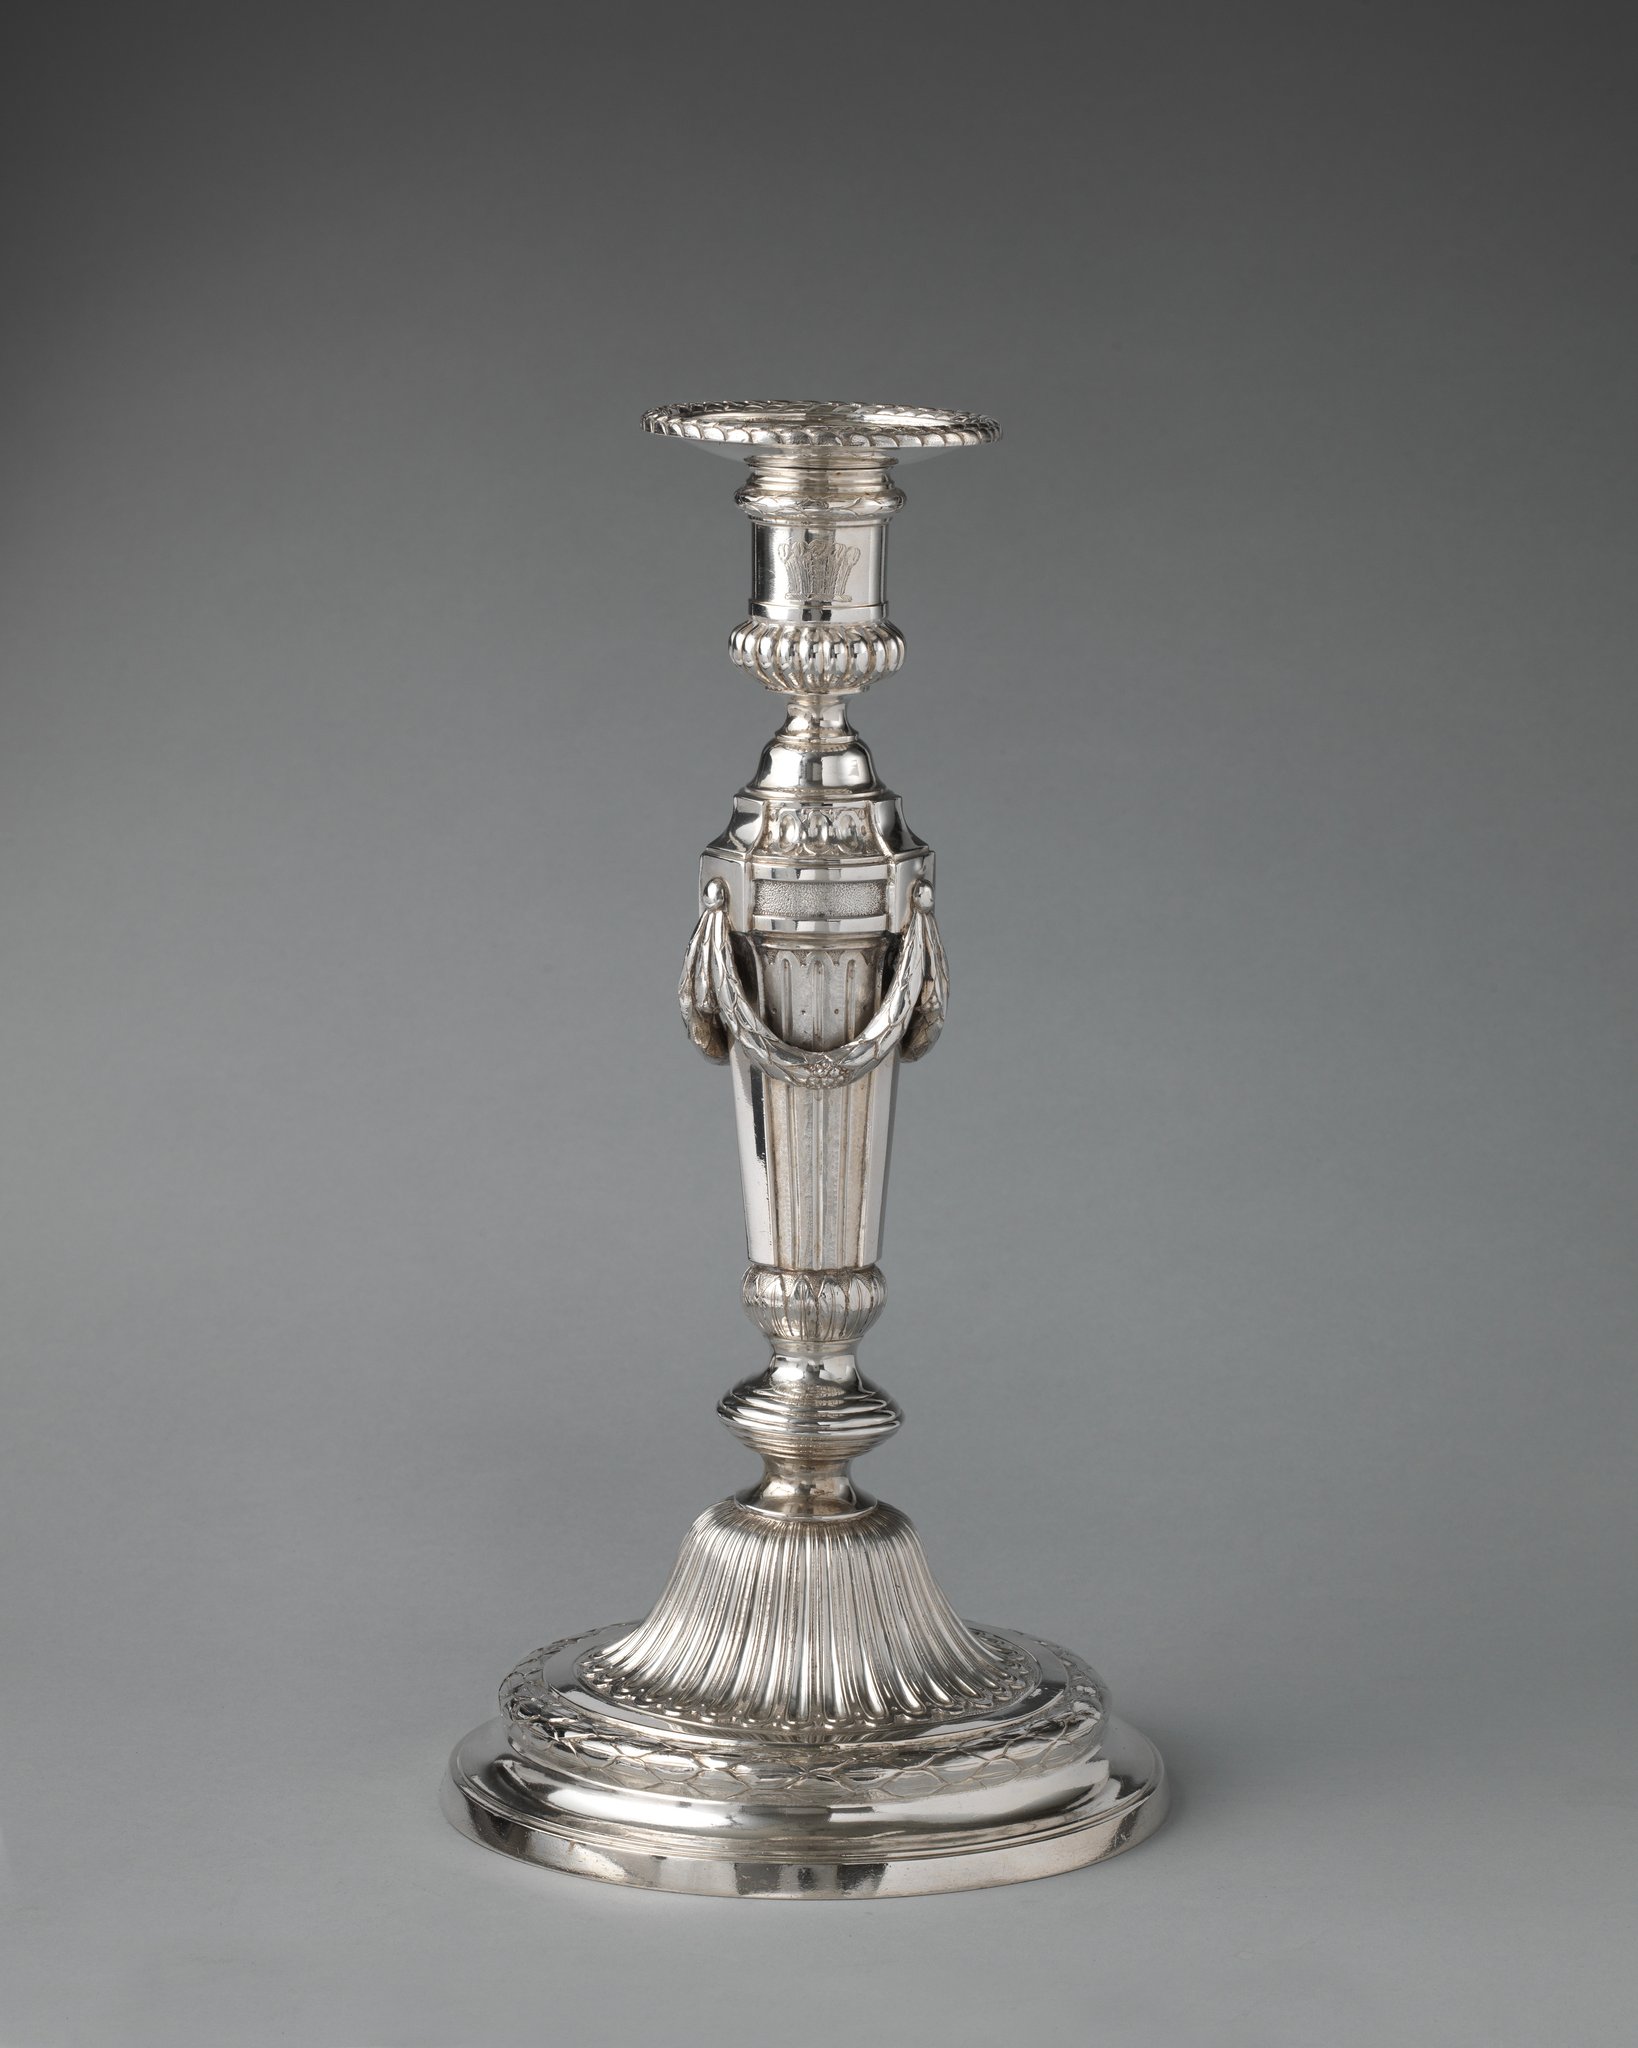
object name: candlestick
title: Candlestick (one of a set of eight)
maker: andrew fogelberg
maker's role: maker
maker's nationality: british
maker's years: 1750-1815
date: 1774-1775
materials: silver